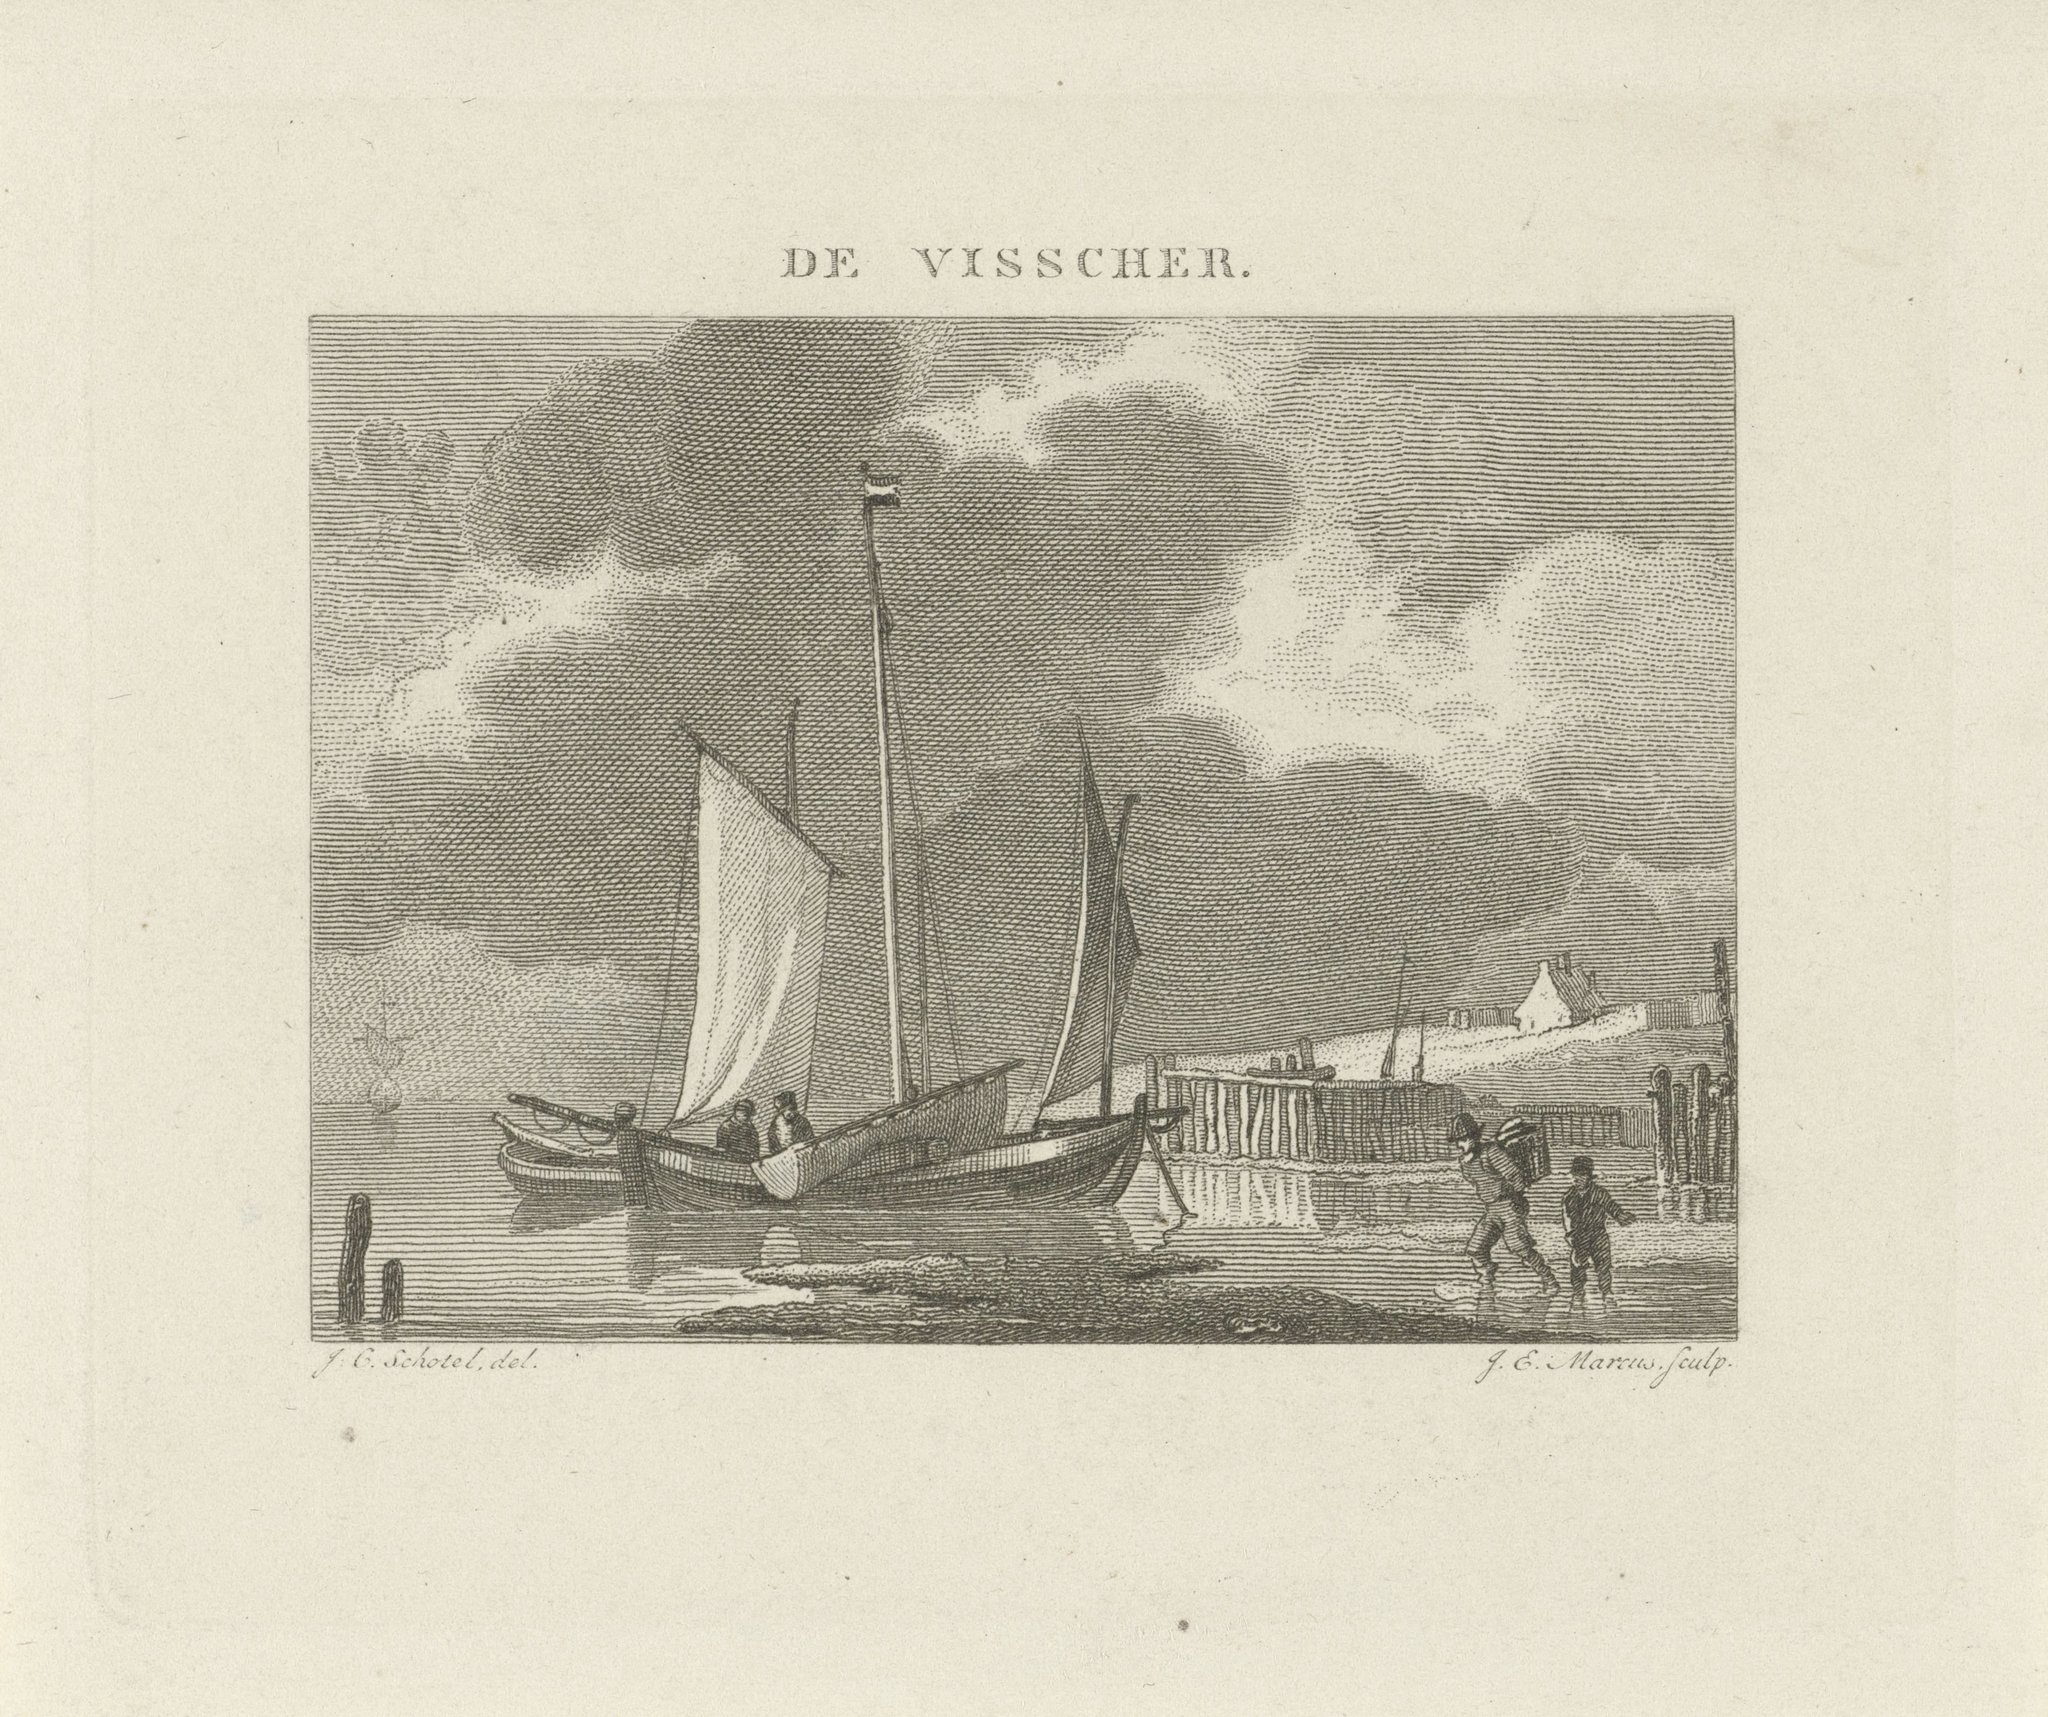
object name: print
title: De visscher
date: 1825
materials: paper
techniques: etching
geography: amsterdam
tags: sailing-ship, sailing-boat, fisherman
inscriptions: collector's mark: Lugt 2228, inscription: ‘Ned. Muzen Alm. 1825’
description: Twee figuren in een boot met zeilen bij een havenhoofd, op de voorgrond loopt een man met een mand op zijn rug en een jongen.